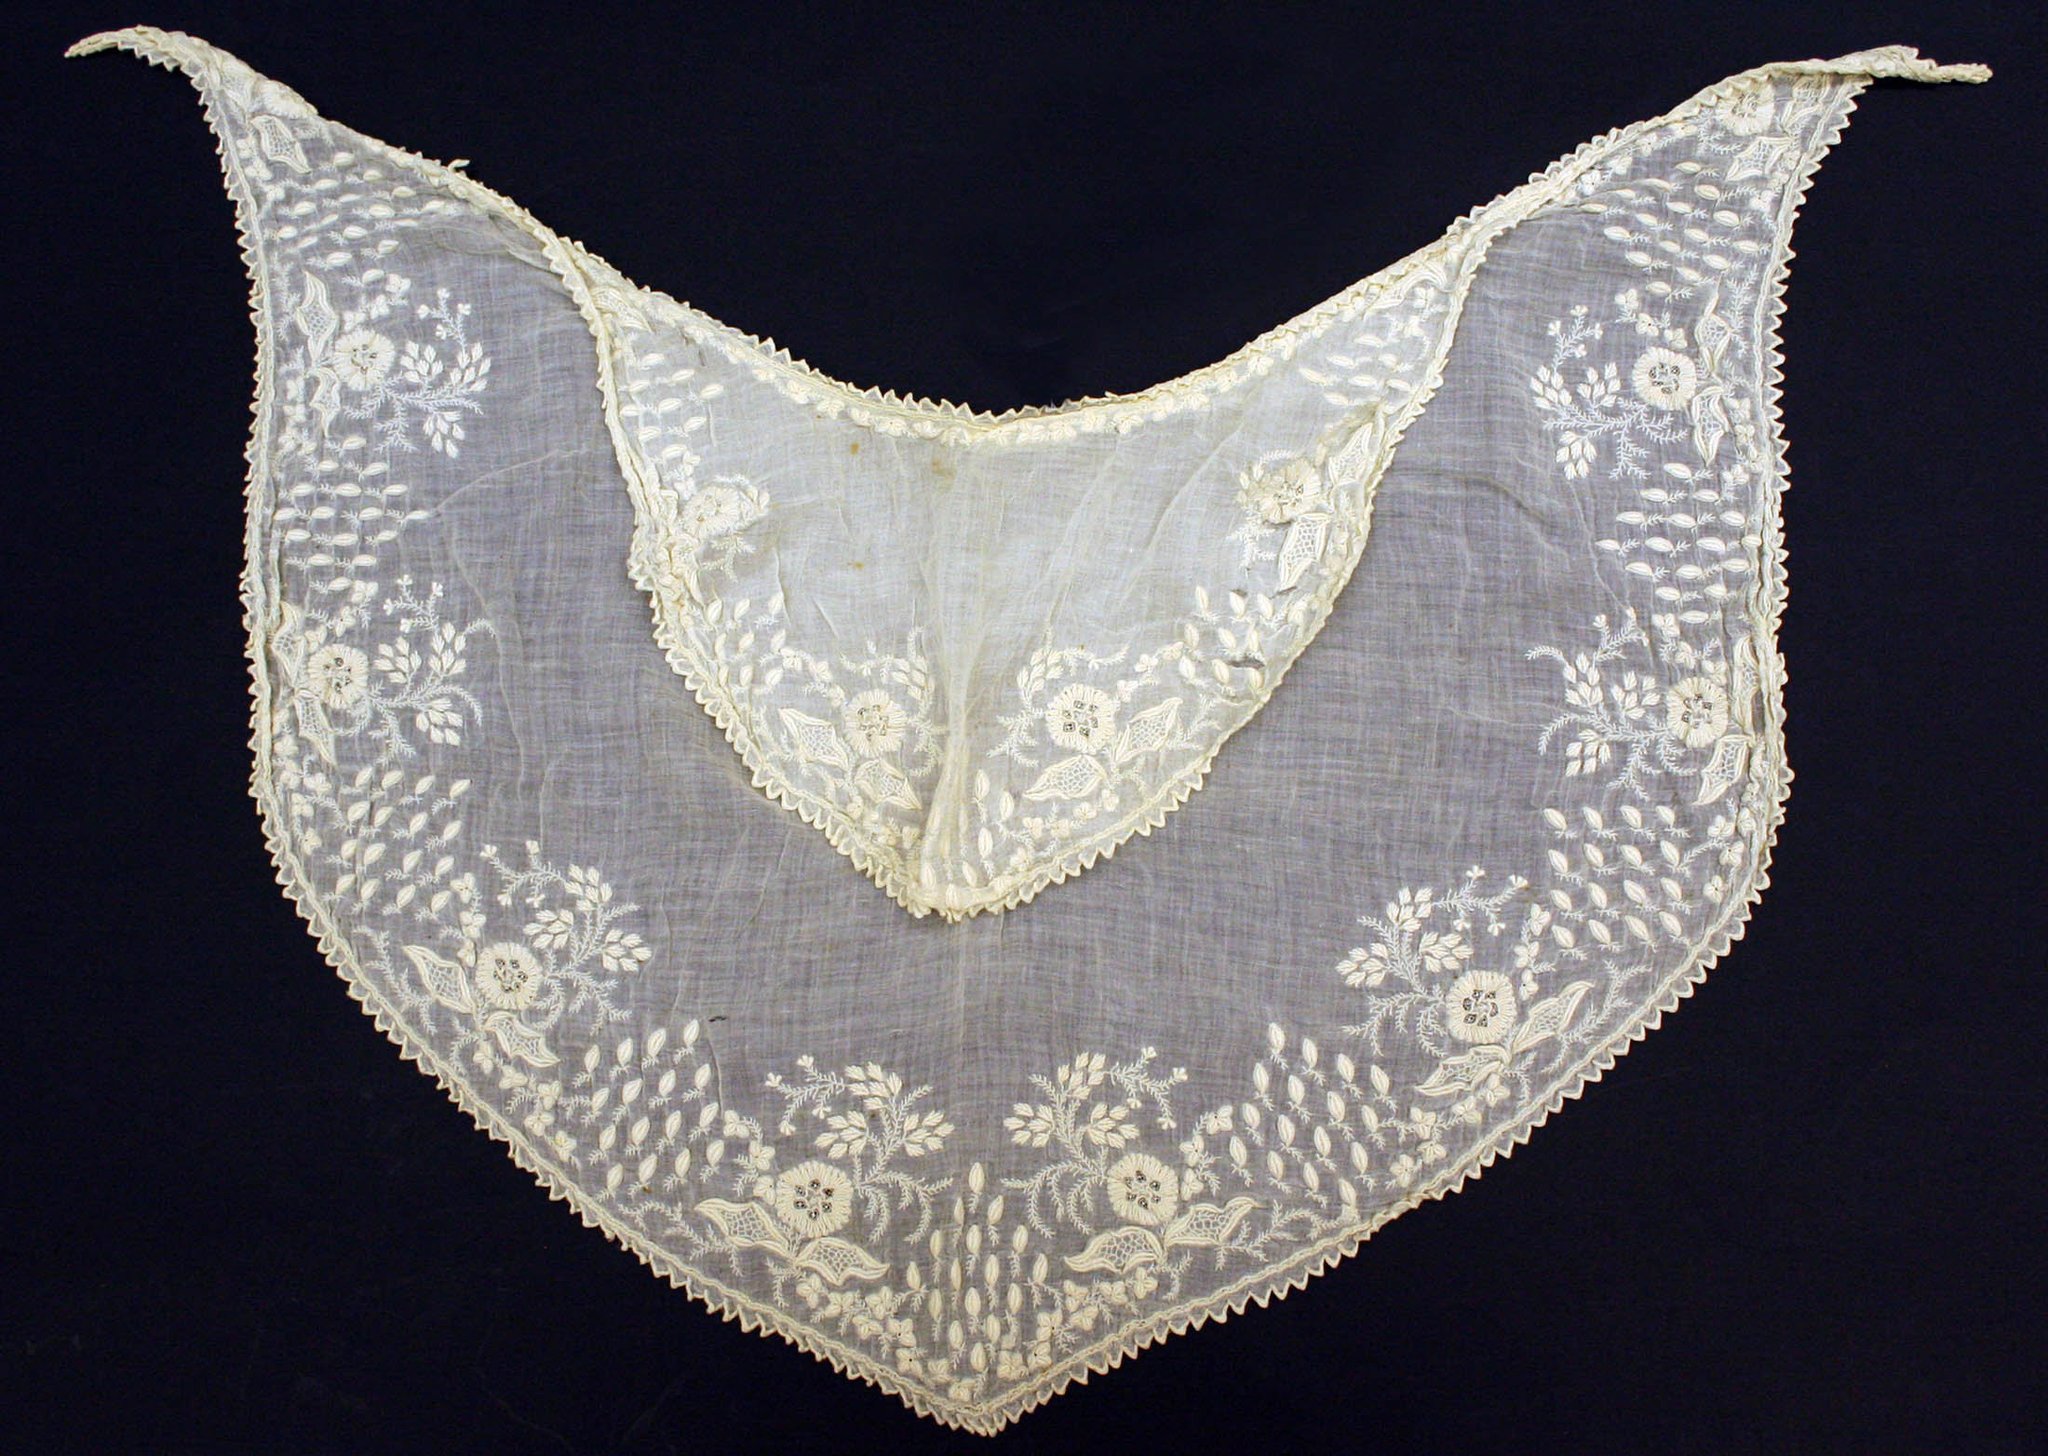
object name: pelerine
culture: american or european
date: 1835-1845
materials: cotton